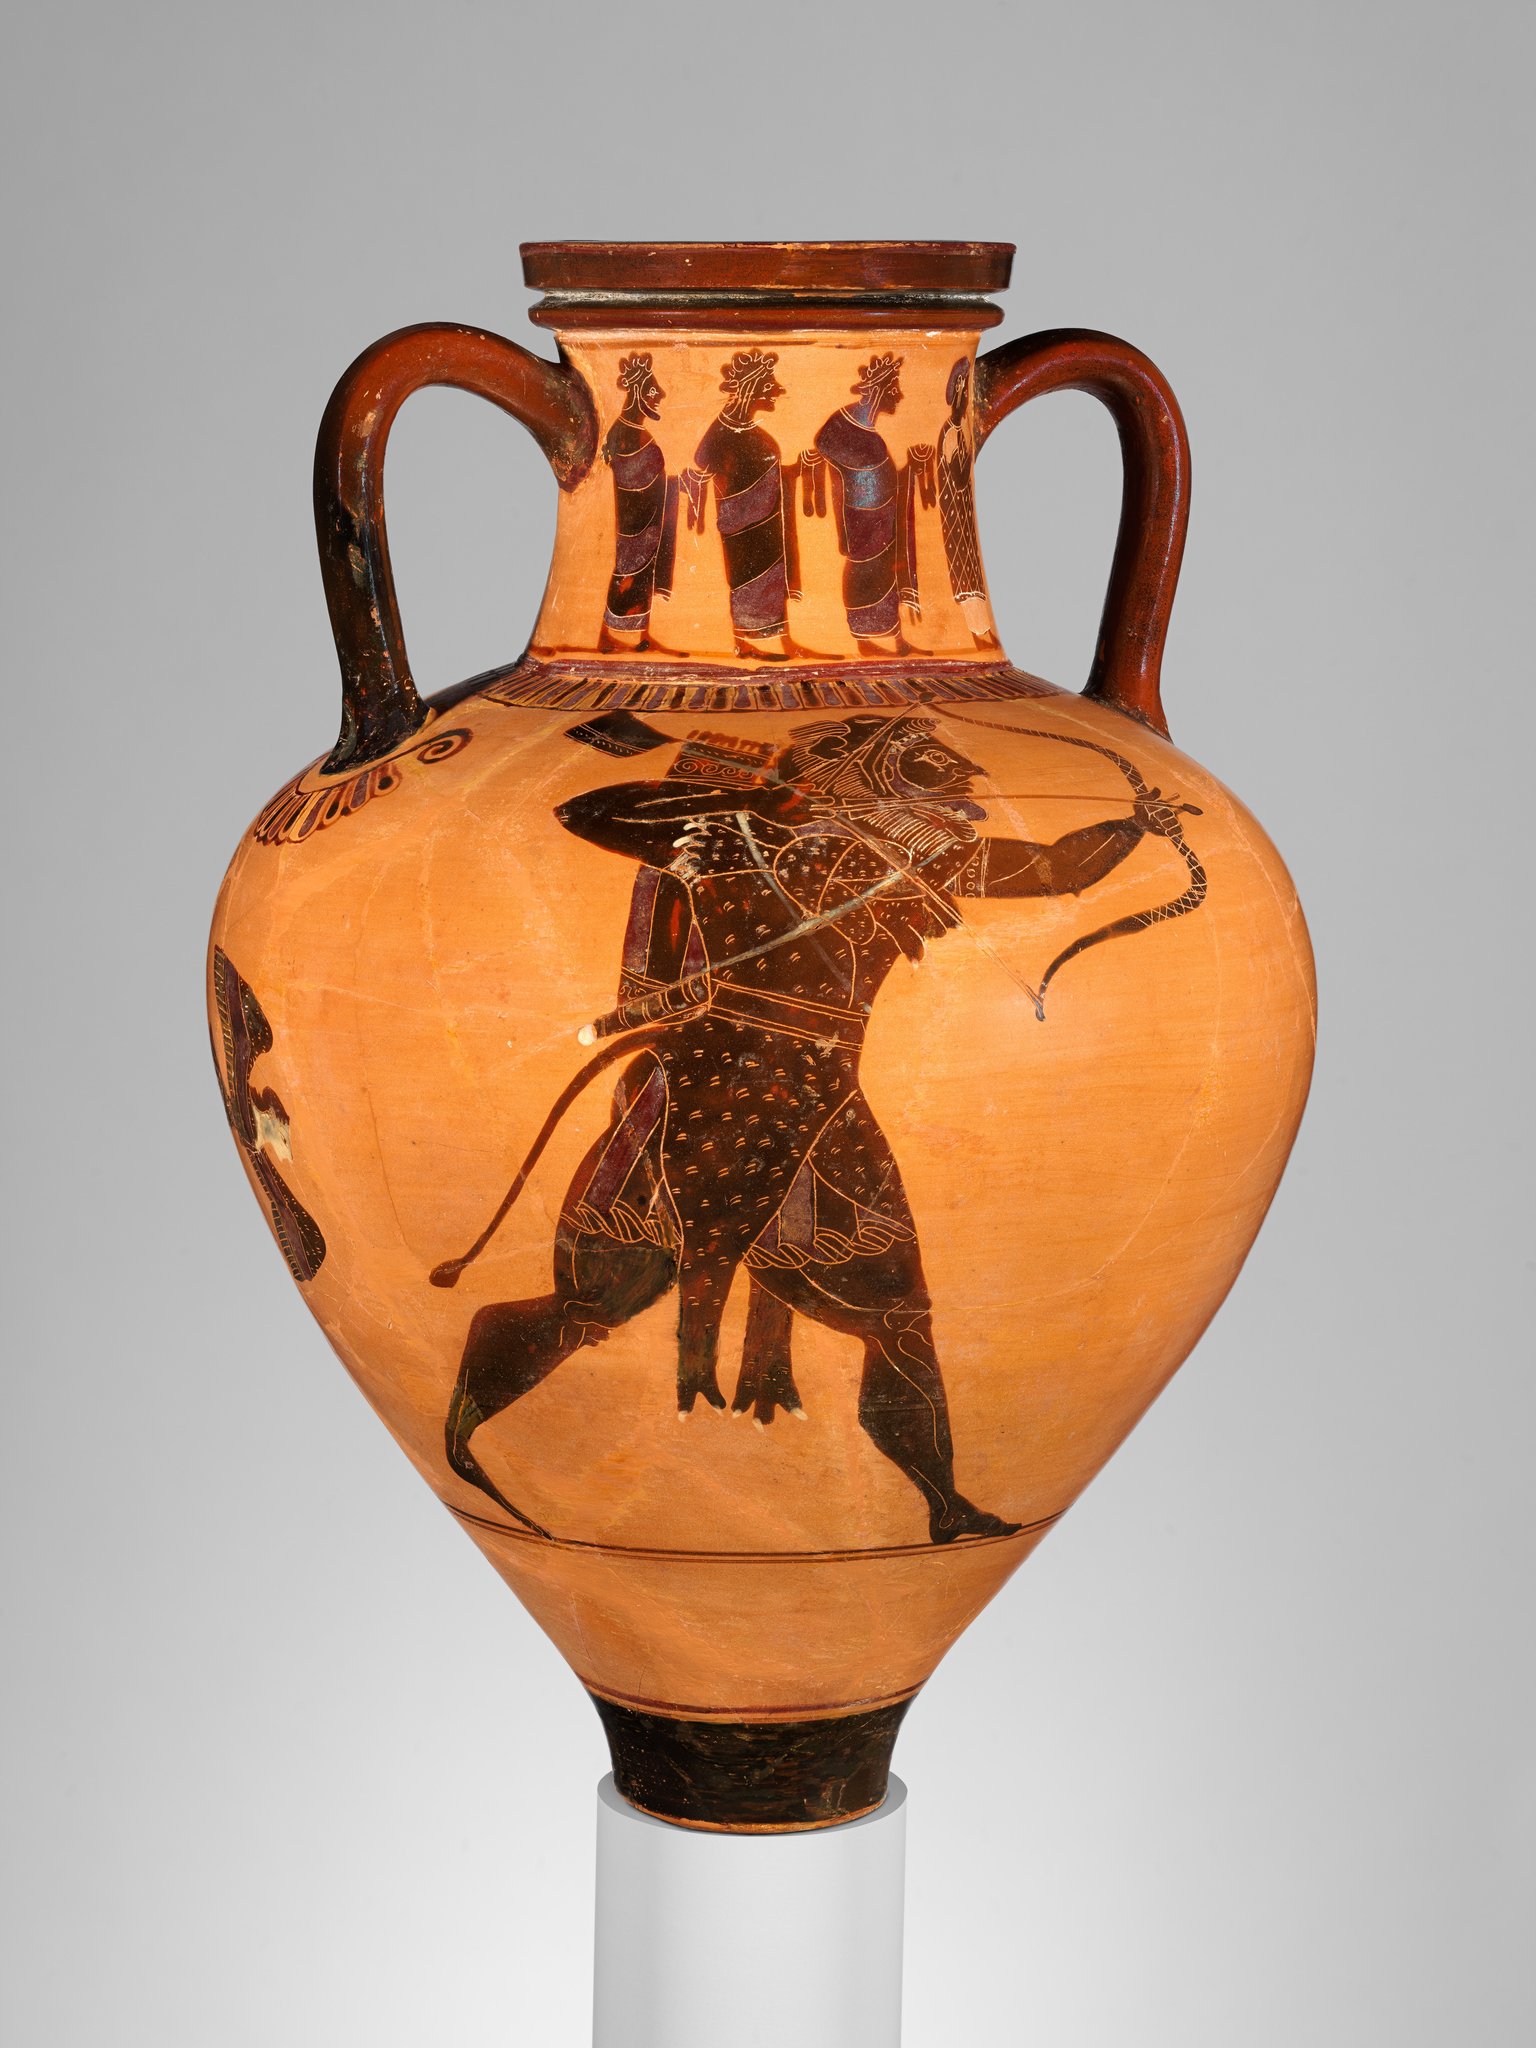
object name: neck amphora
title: Terracotta neck-amphora (jar)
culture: greek, attic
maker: princeton group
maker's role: artist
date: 540-530 BCE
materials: terracotta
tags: bow and arrow,shields,men,herakles